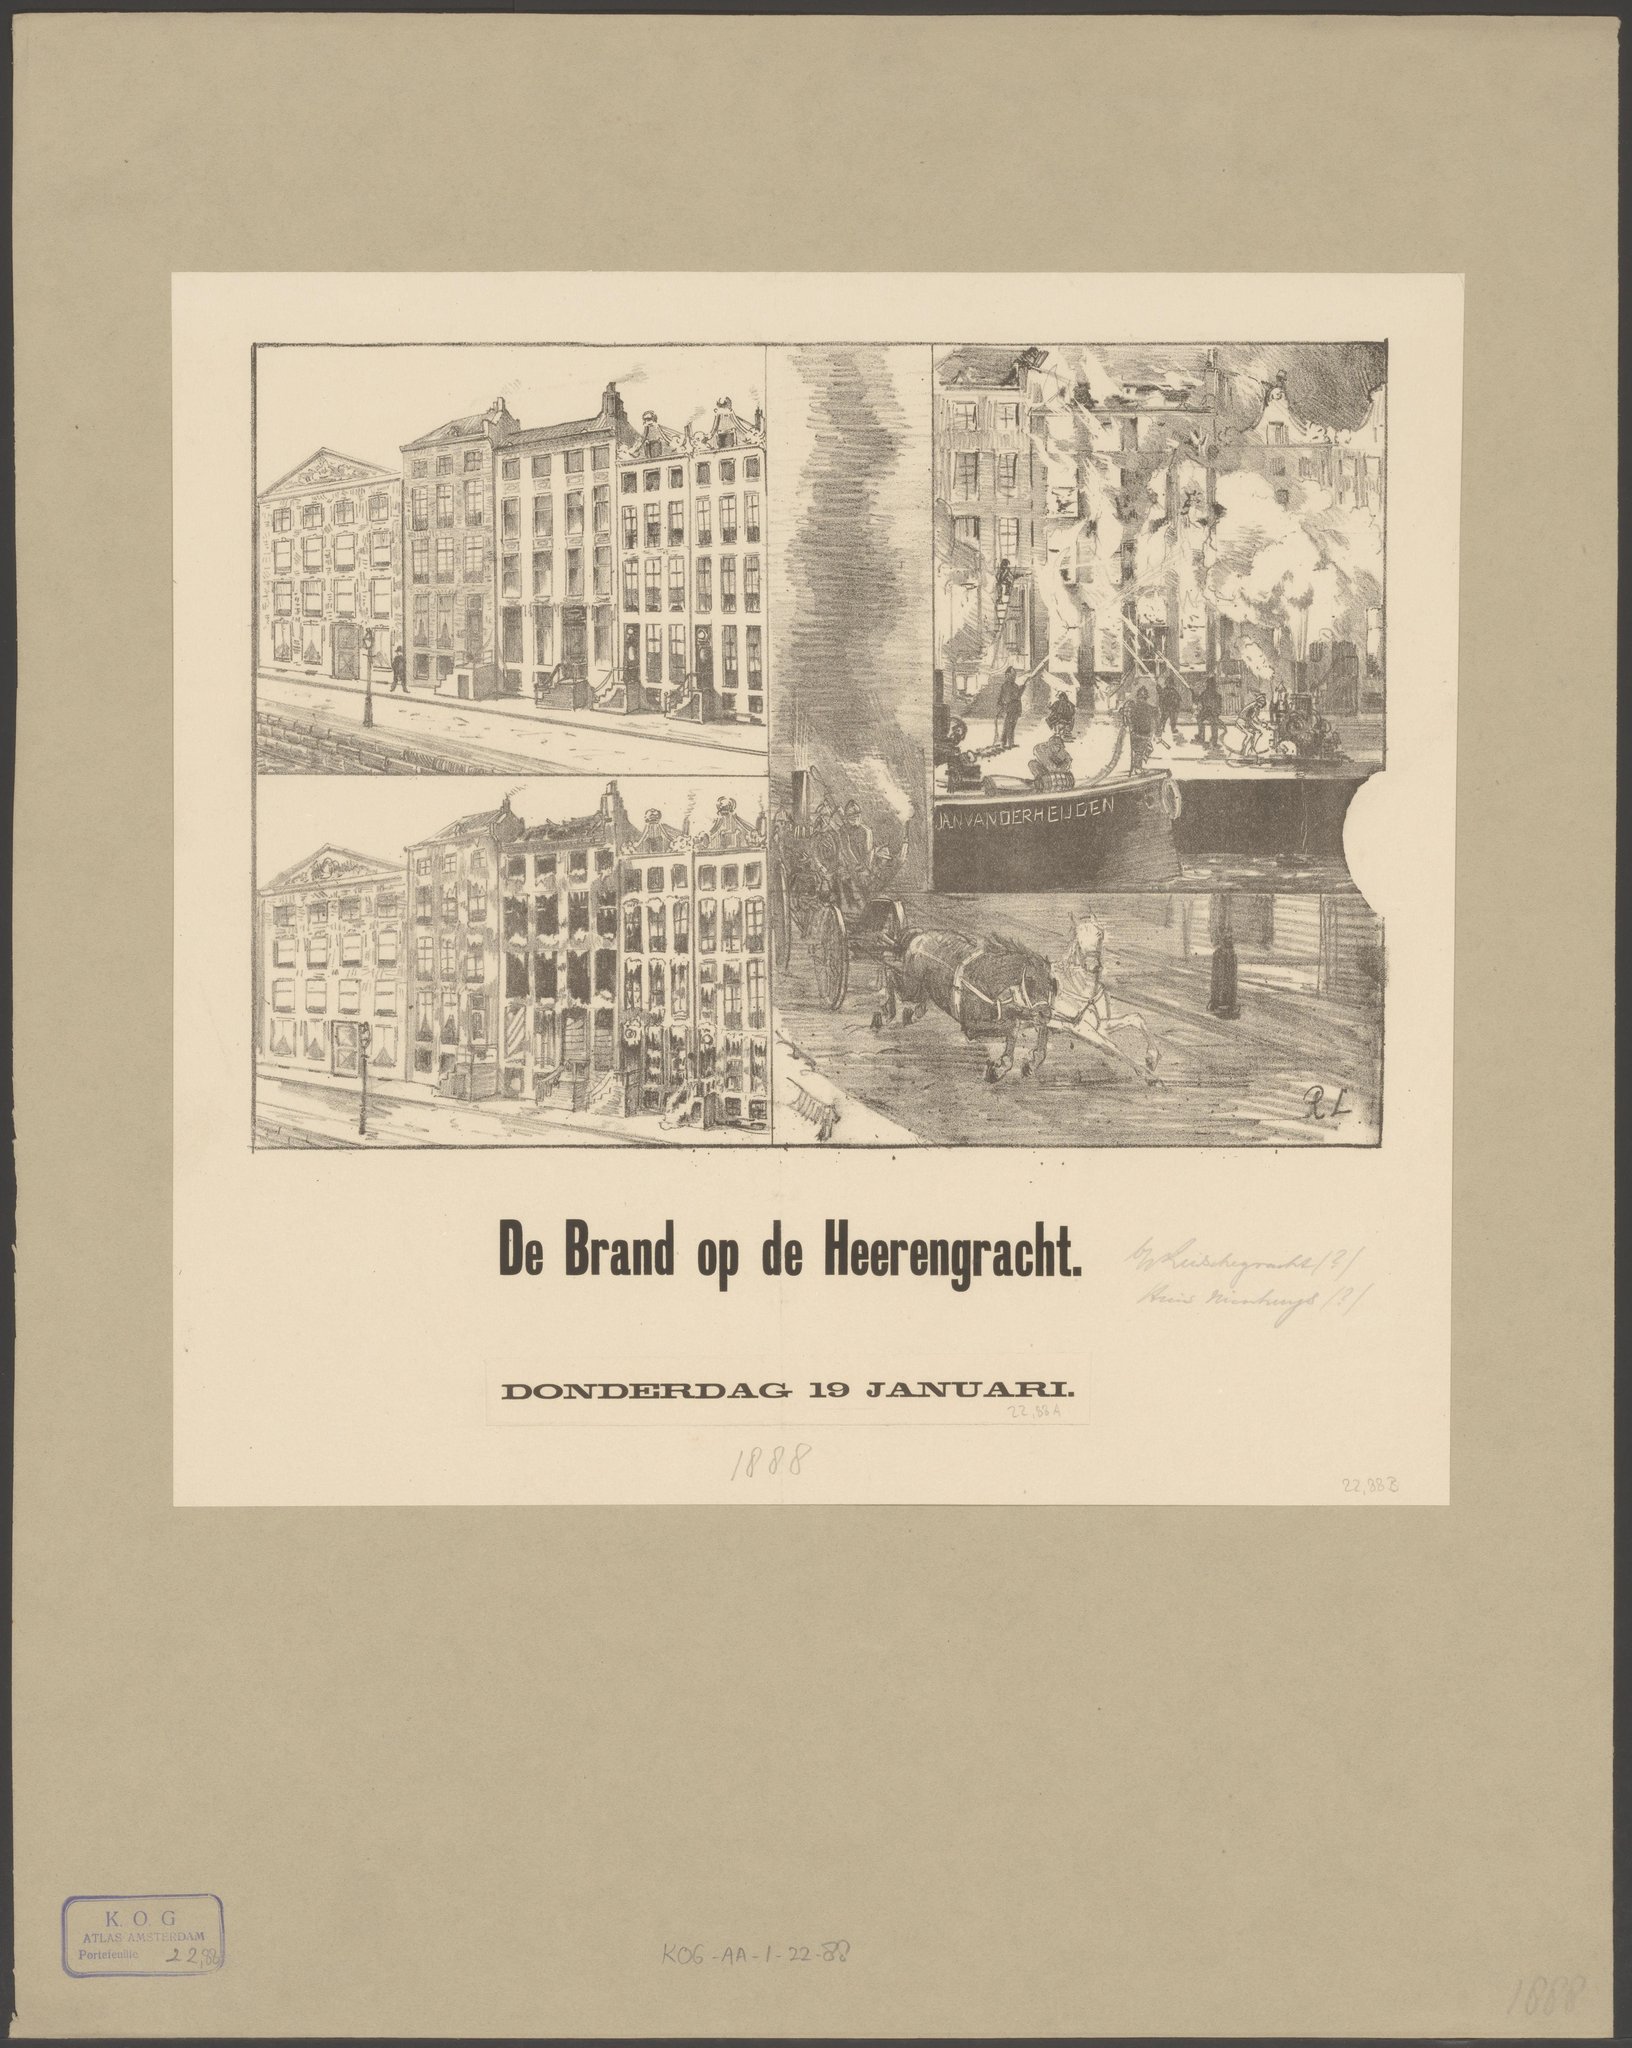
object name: print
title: De Brand op de Heerengracht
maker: Anonymous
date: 1888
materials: paper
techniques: letterpress printing, lithograph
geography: netherlands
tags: urban housing, on fire, ablaze, fire-fighting, four-wheeled vehicle drawn by two animals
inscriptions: collector's mark: Lugt 1641b, signature: ‘RL’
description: Onderwerpsrubriek binnen de Atlas Amsterdam: Gemeentewerken: B. Branden in particuliere gebouwen.